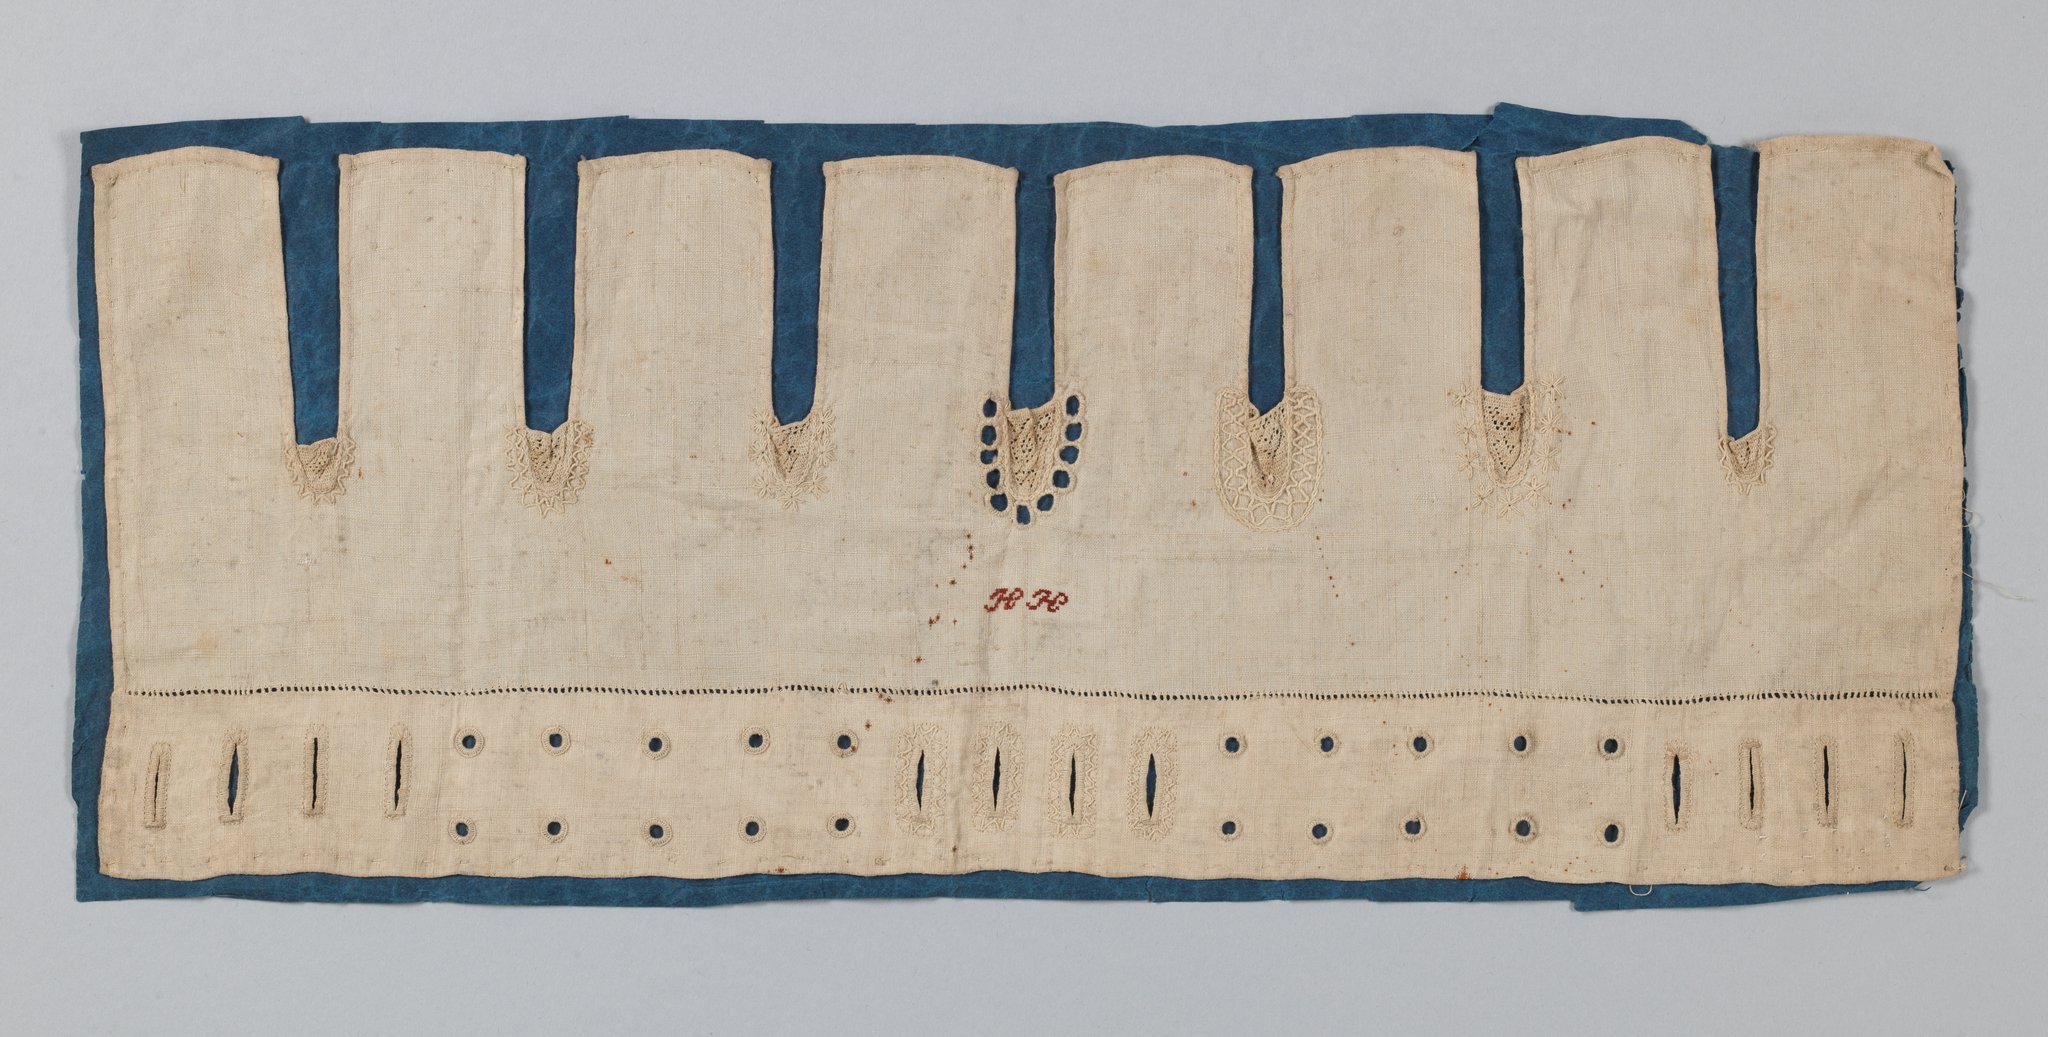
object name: sampler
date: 1701-1800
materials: linen, silk